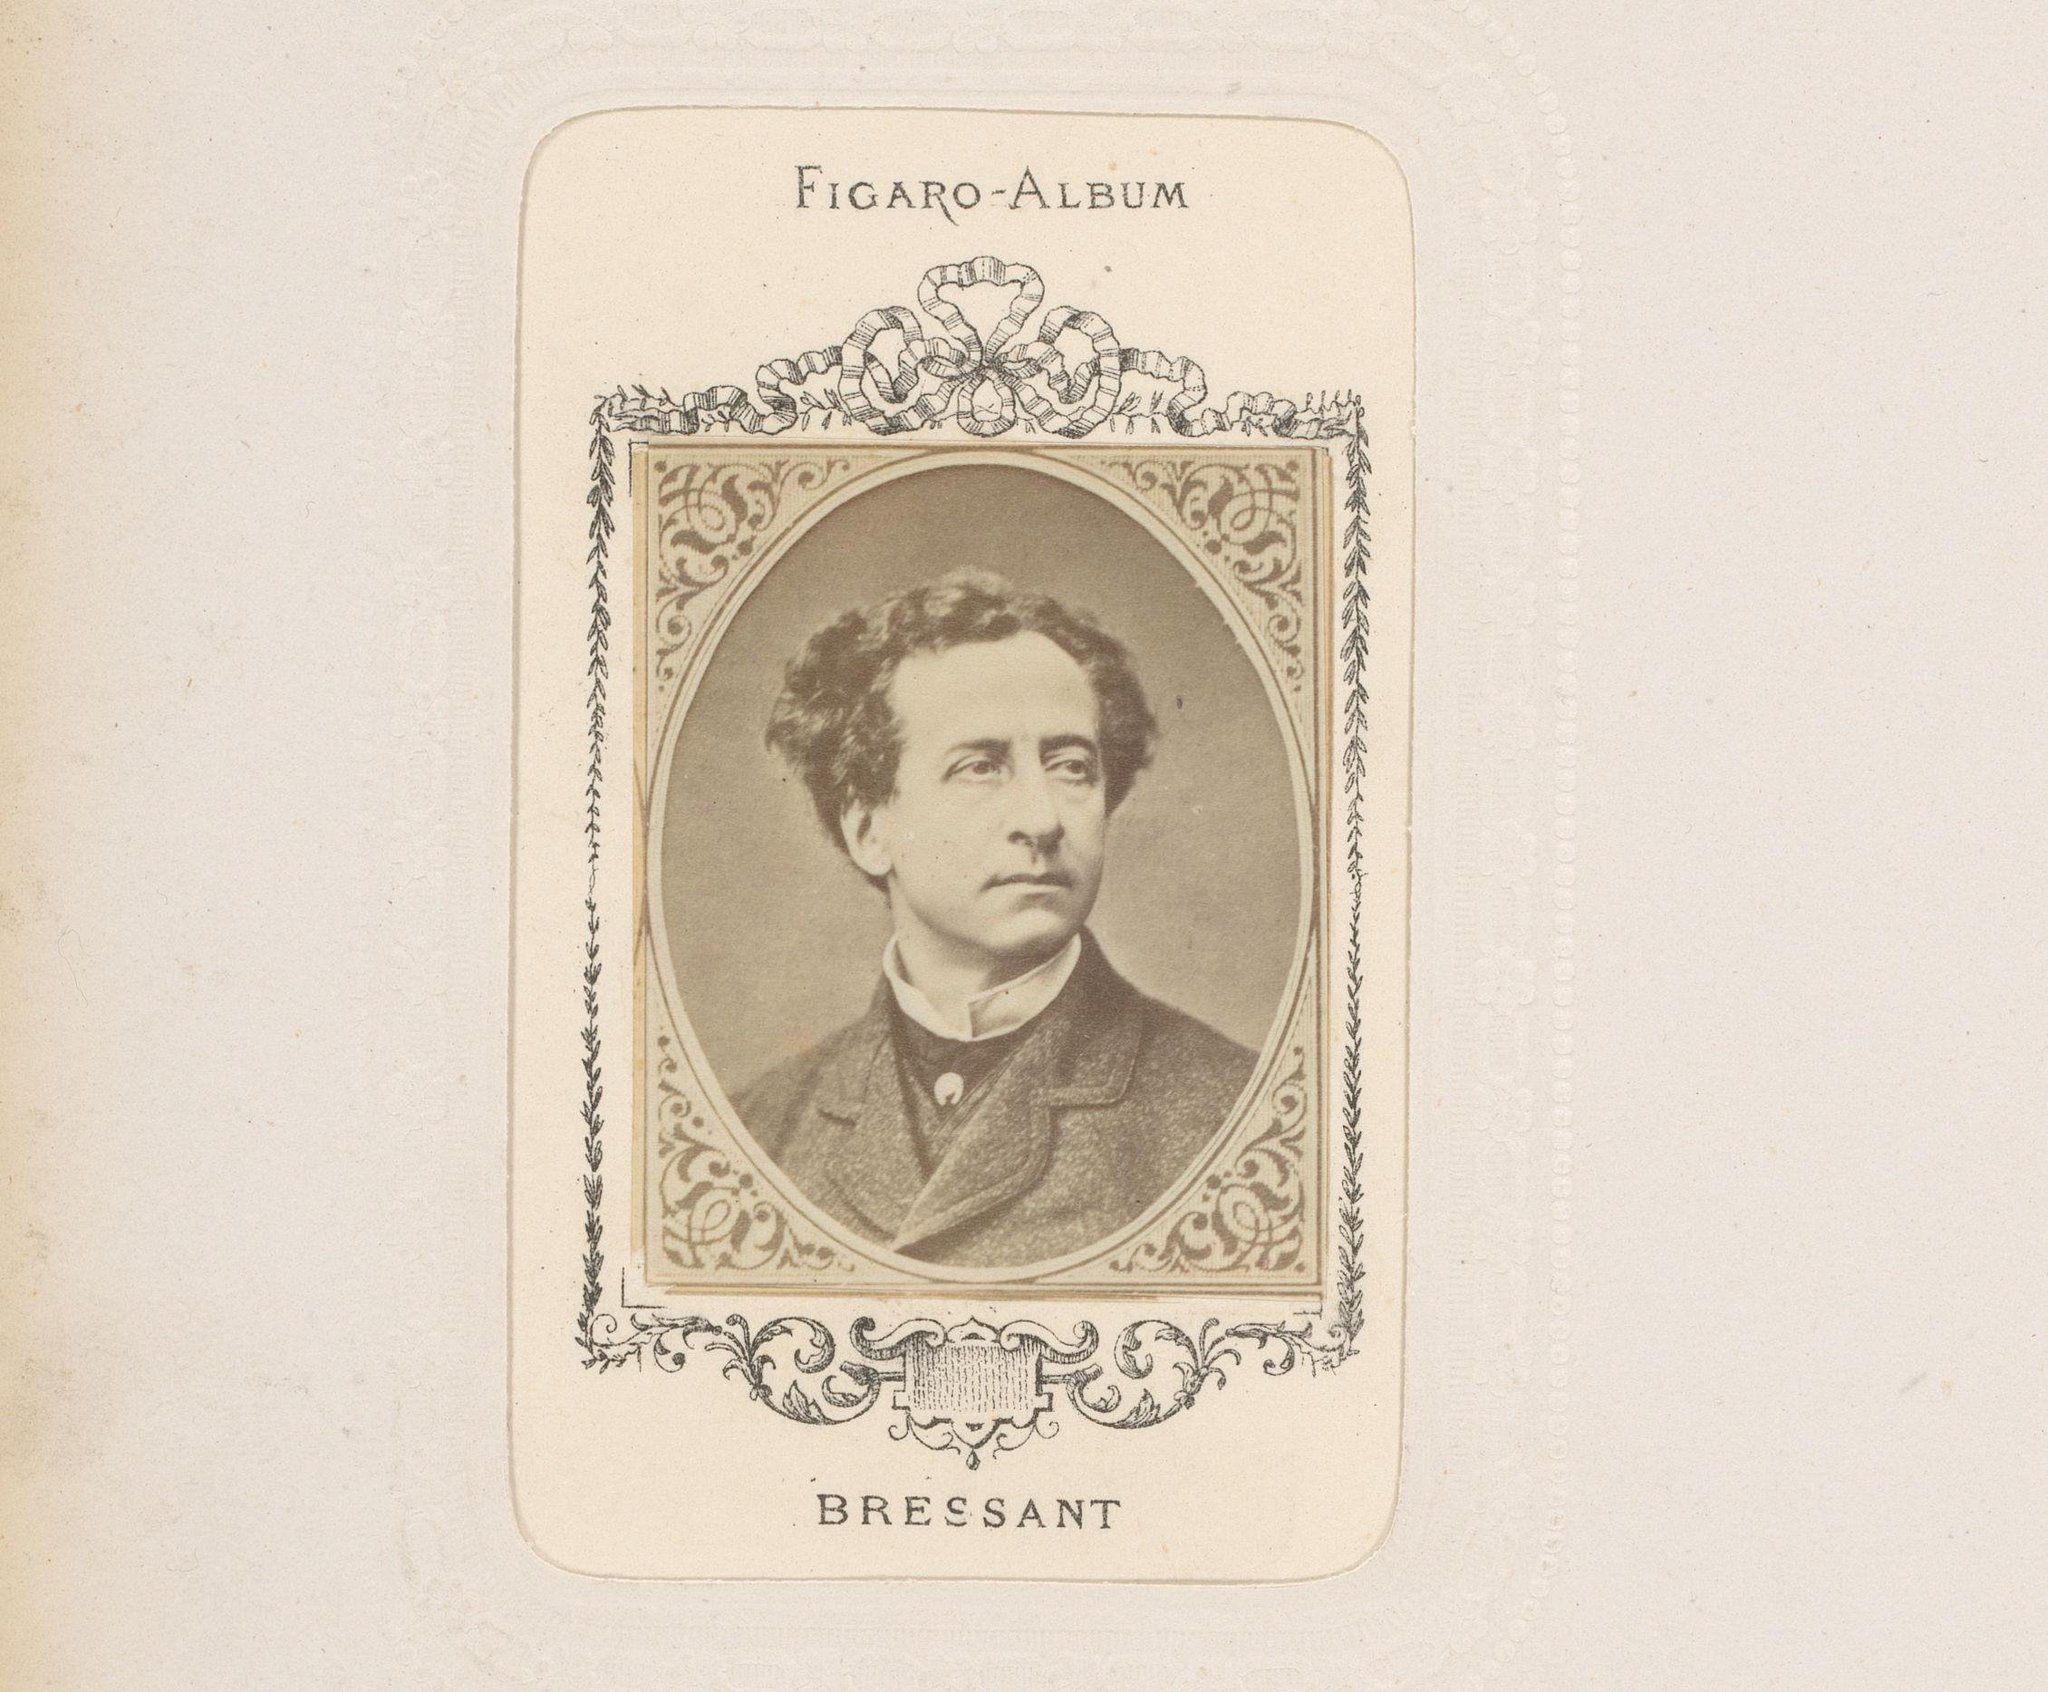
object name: photograph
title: Fotoreproductie van een portret van Jean Baptiste Prosper Bressant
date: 1860-1900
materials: cardboard, photographic support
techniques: albumen print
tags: historical persons, portrait of actor, actress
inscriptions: inscription: ‘Figaro-Album/ Bressant/ d'après Mulnier Phot.’